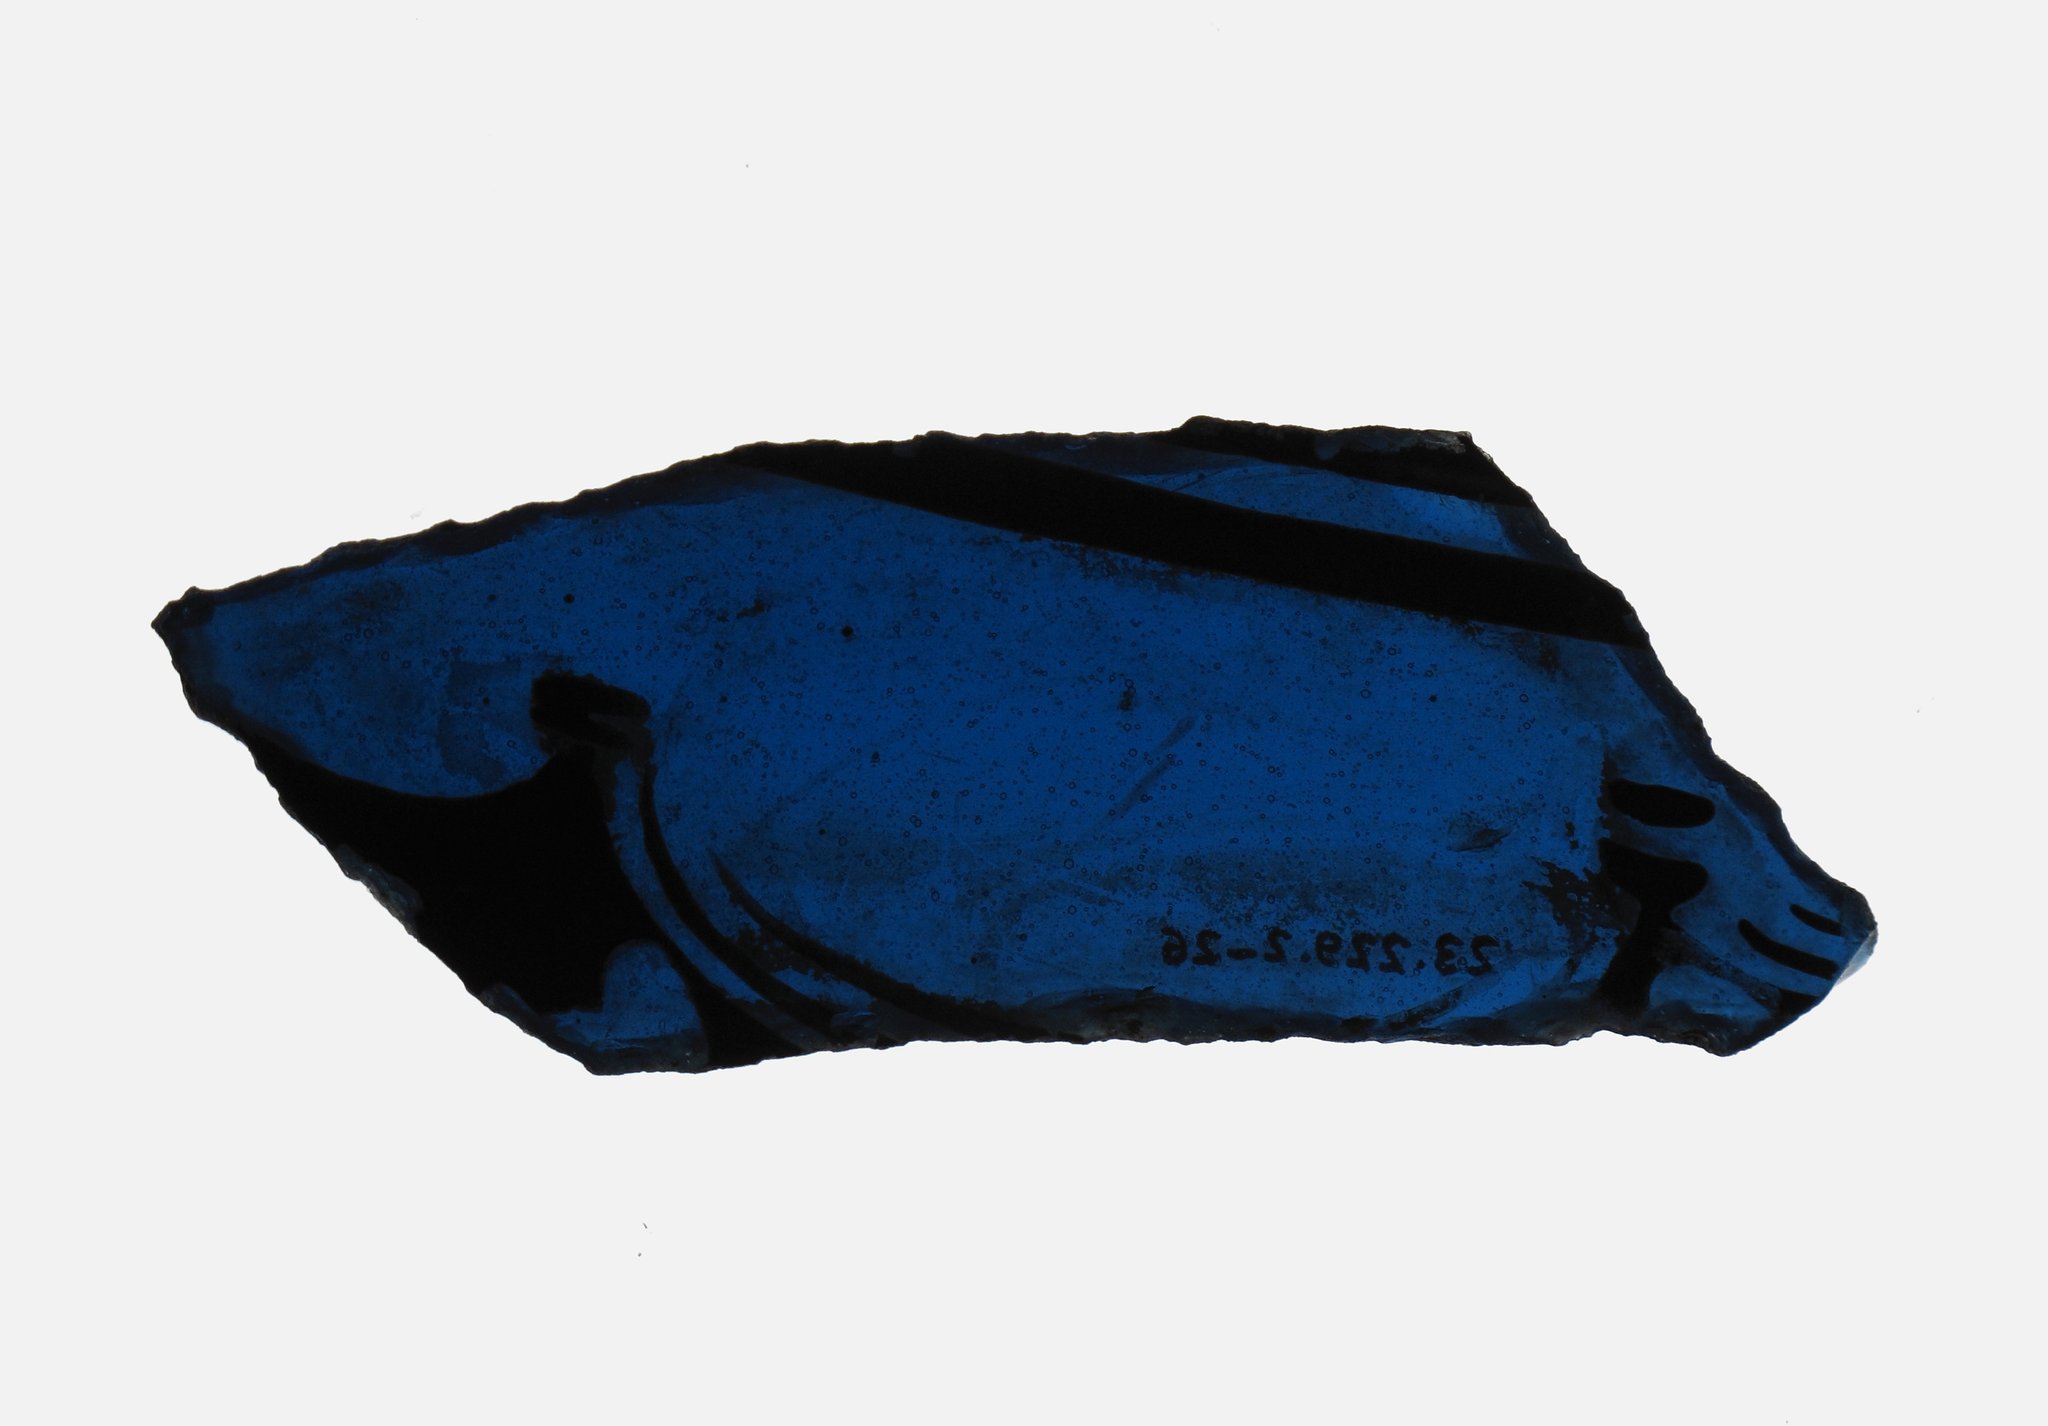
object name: fragment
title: Glass Fragment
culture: french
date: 1201-1300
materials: glass, metal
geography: france